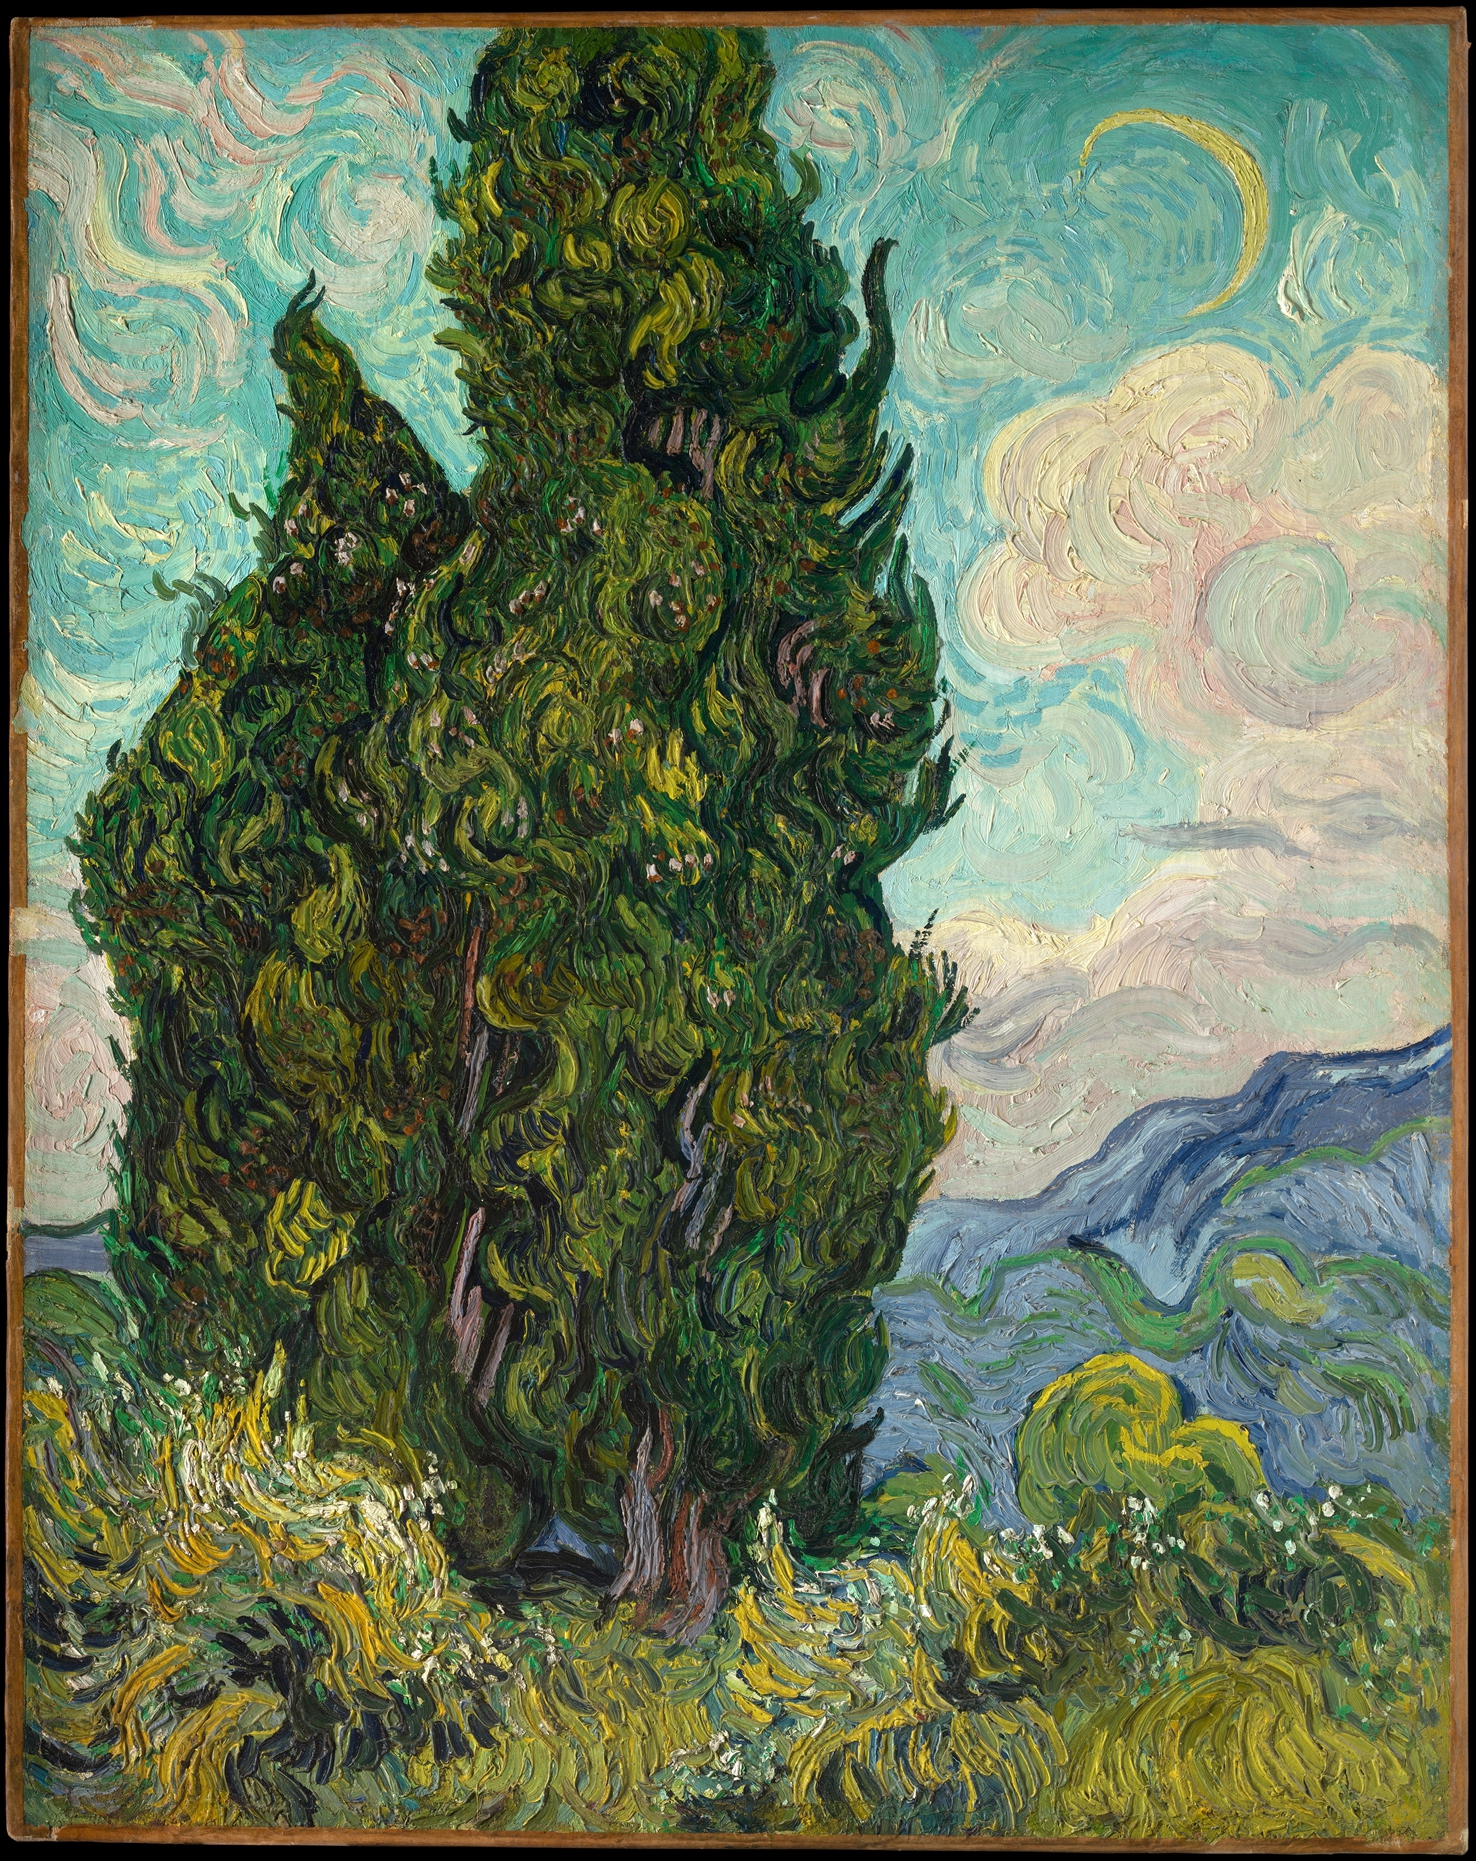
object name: painting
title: Cypresses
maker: vincent van gogh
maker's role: artist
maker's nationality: dutch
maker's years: 1853-1890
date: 1889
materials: canvas, oil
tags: landscapes,cypresses